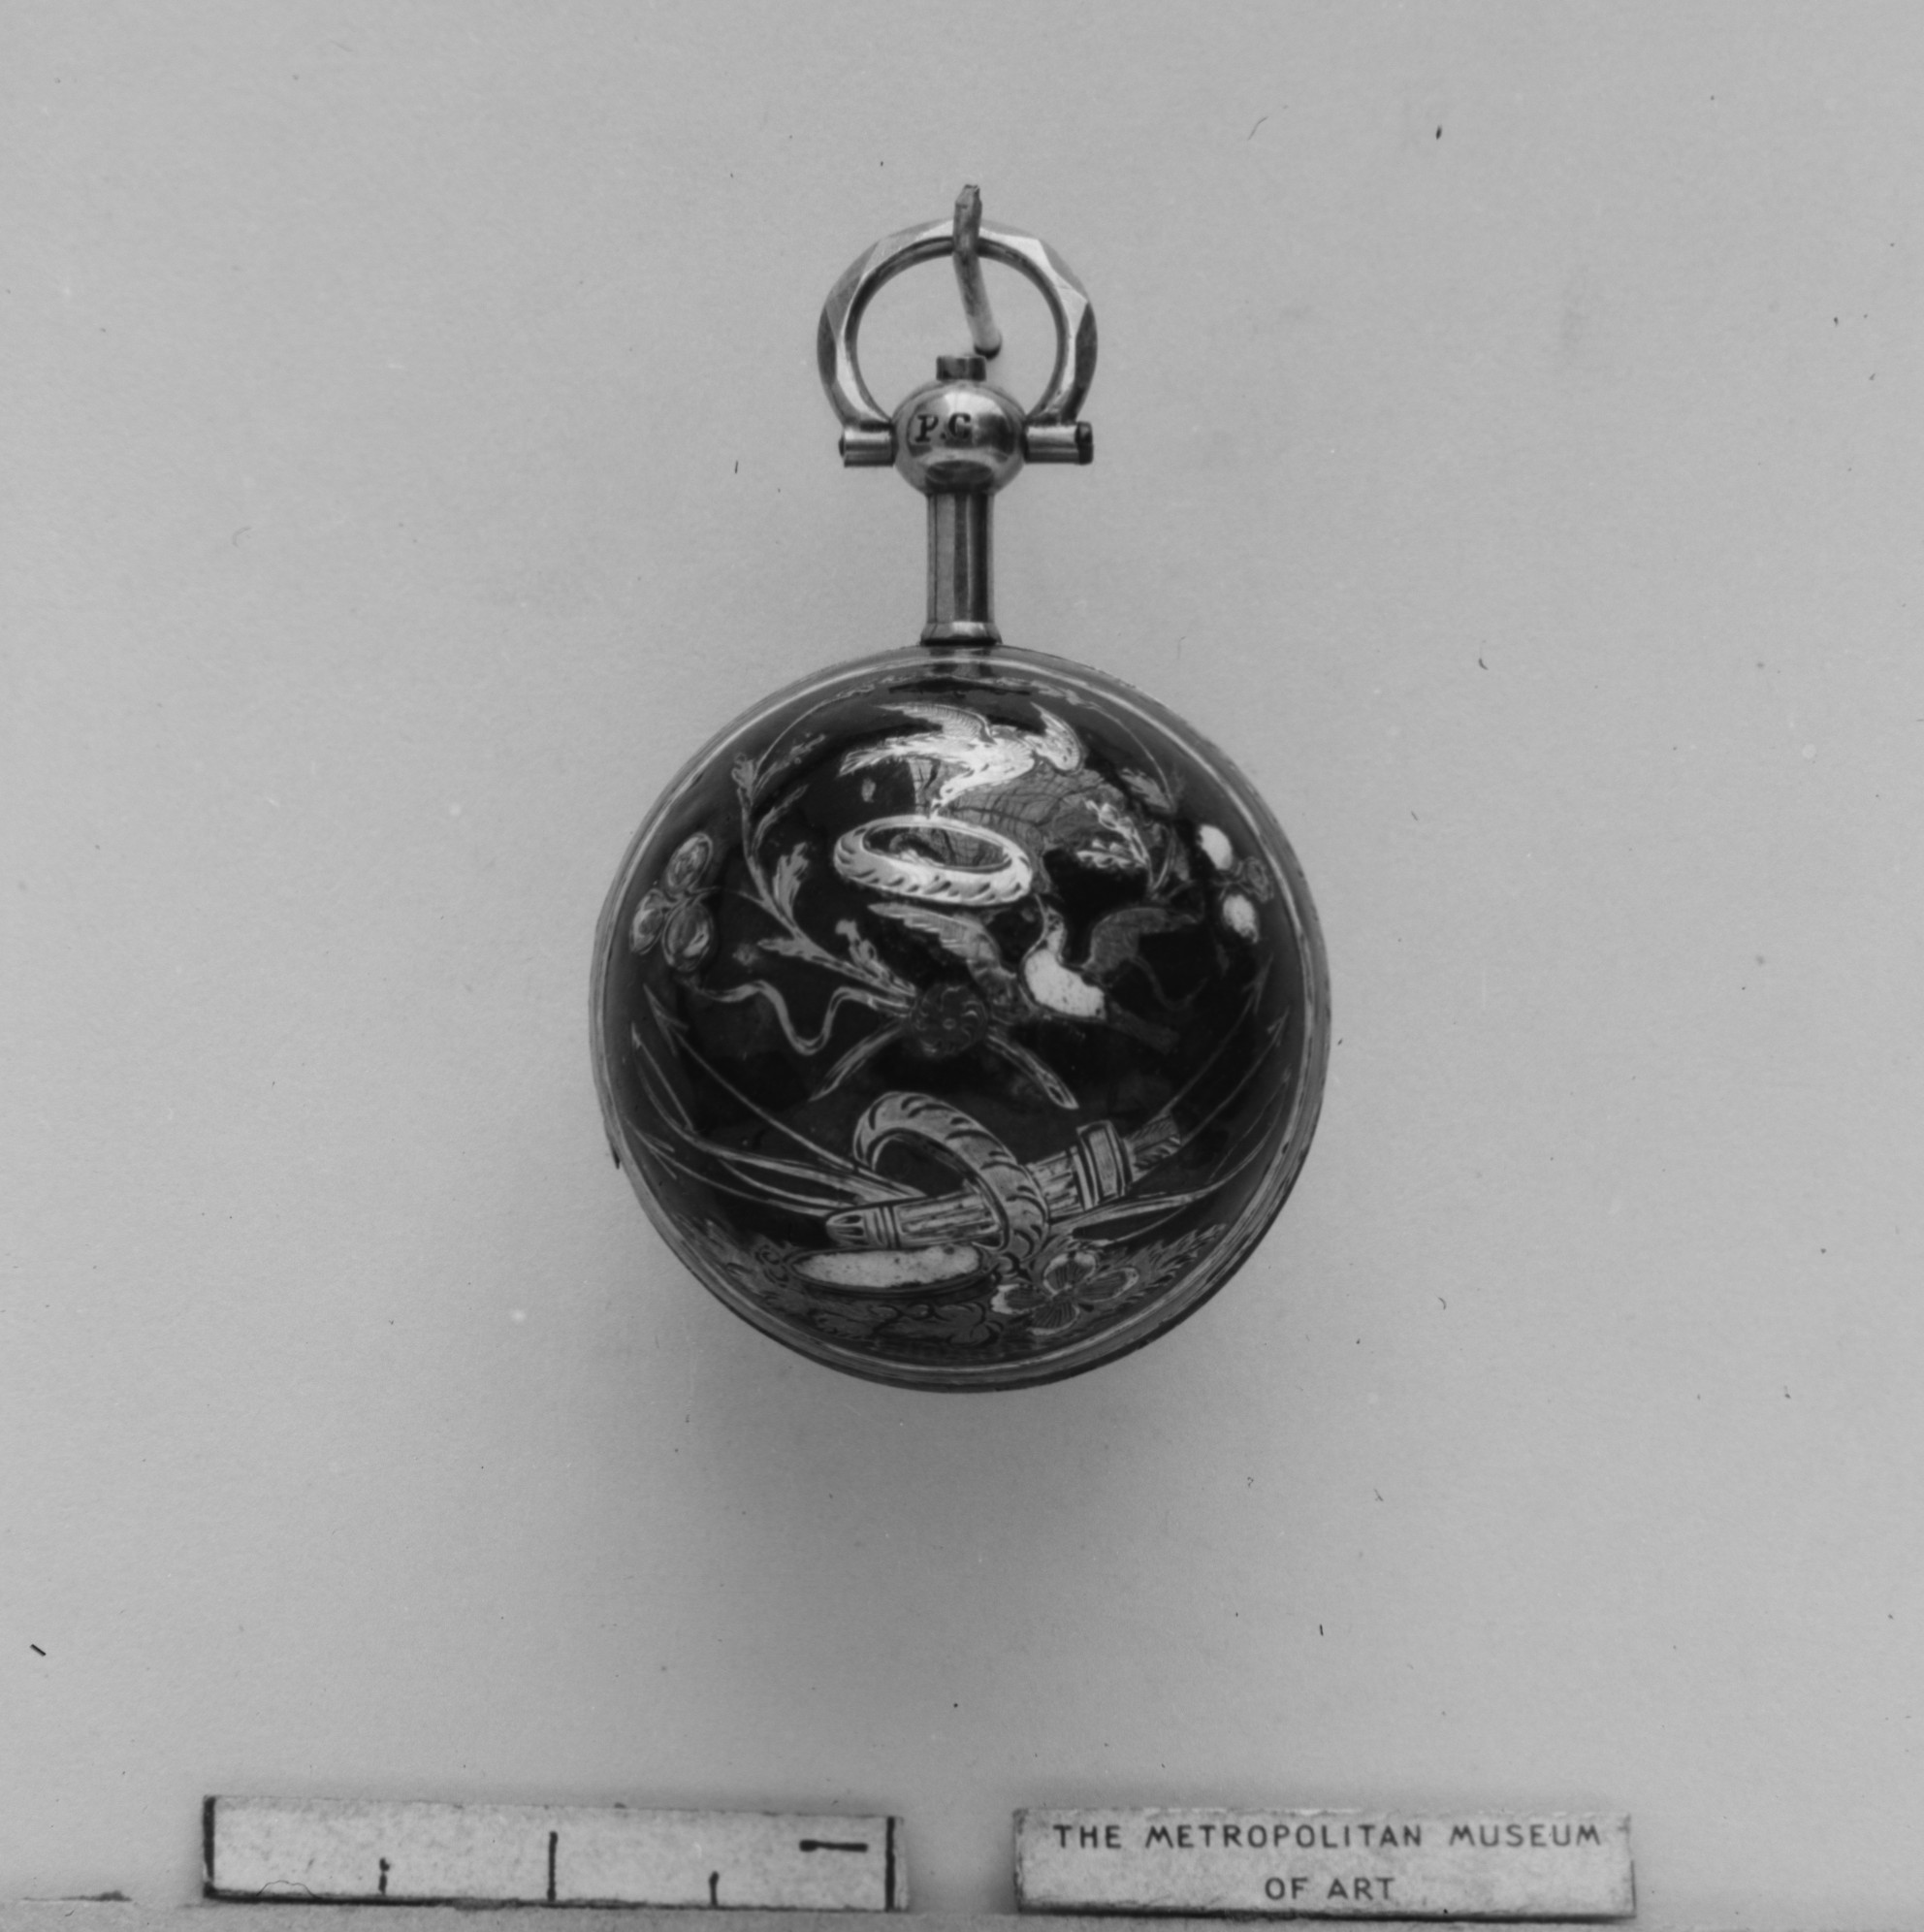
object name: watch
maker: j. patron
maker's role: maker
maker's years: 1700-1800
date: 1701-1800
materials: enamel, metal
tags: birds